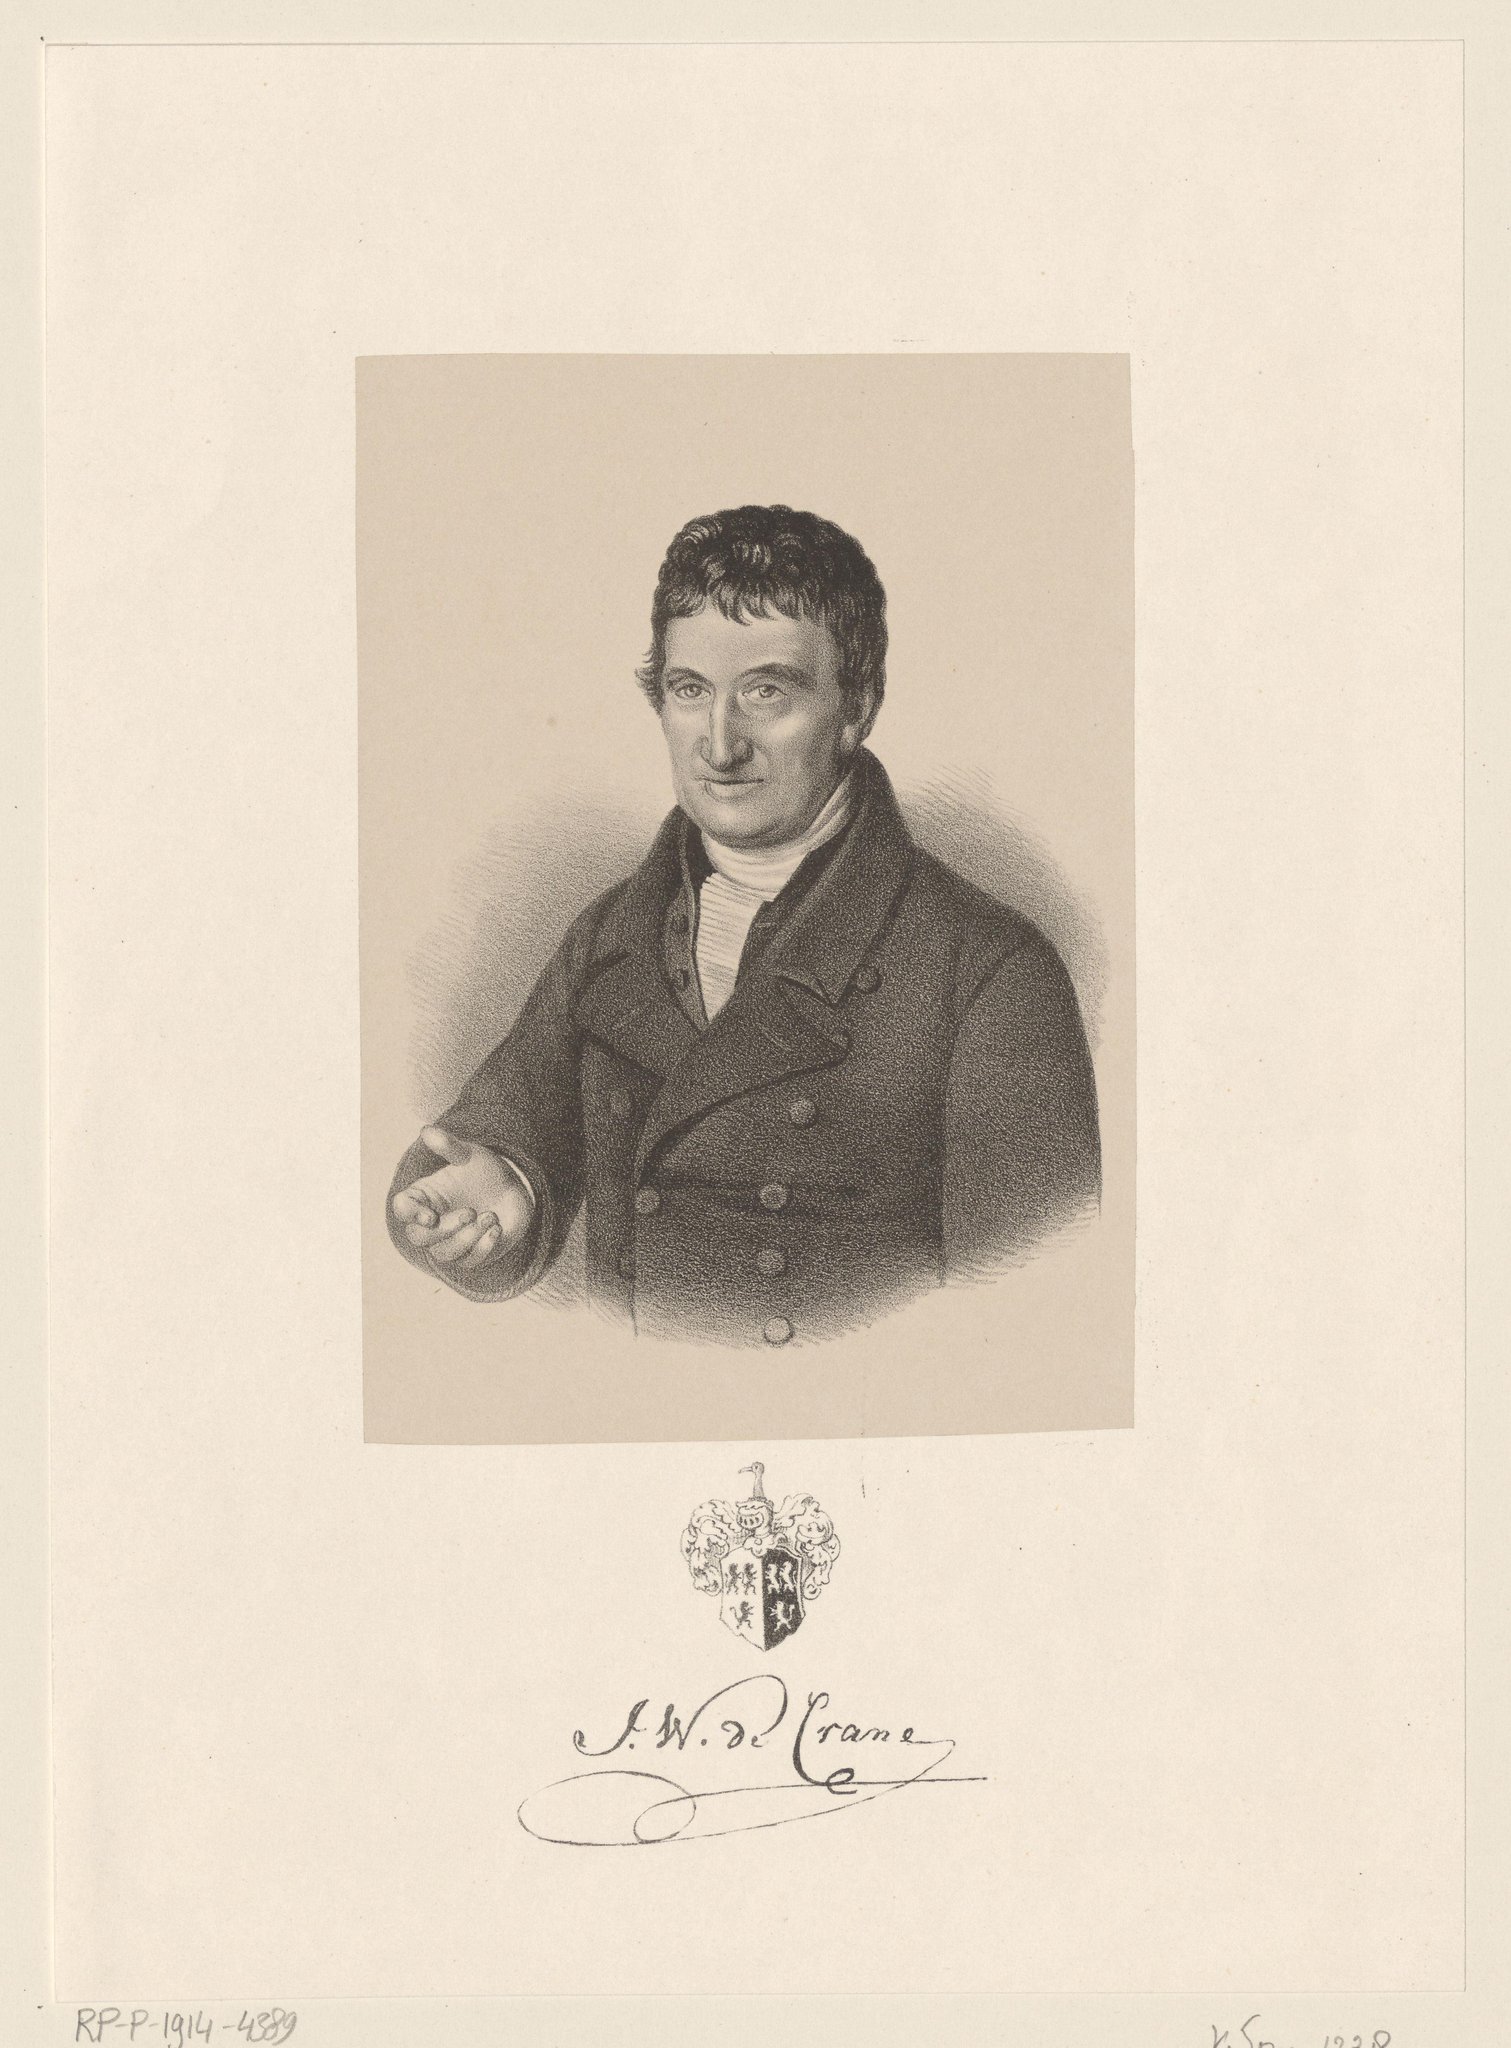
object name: print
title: Portret van Jan Willem de Crane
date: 1788-1899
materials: paper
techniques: lithograph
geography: the hague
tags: historical persons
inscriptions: collector's mark: Lugt 2228